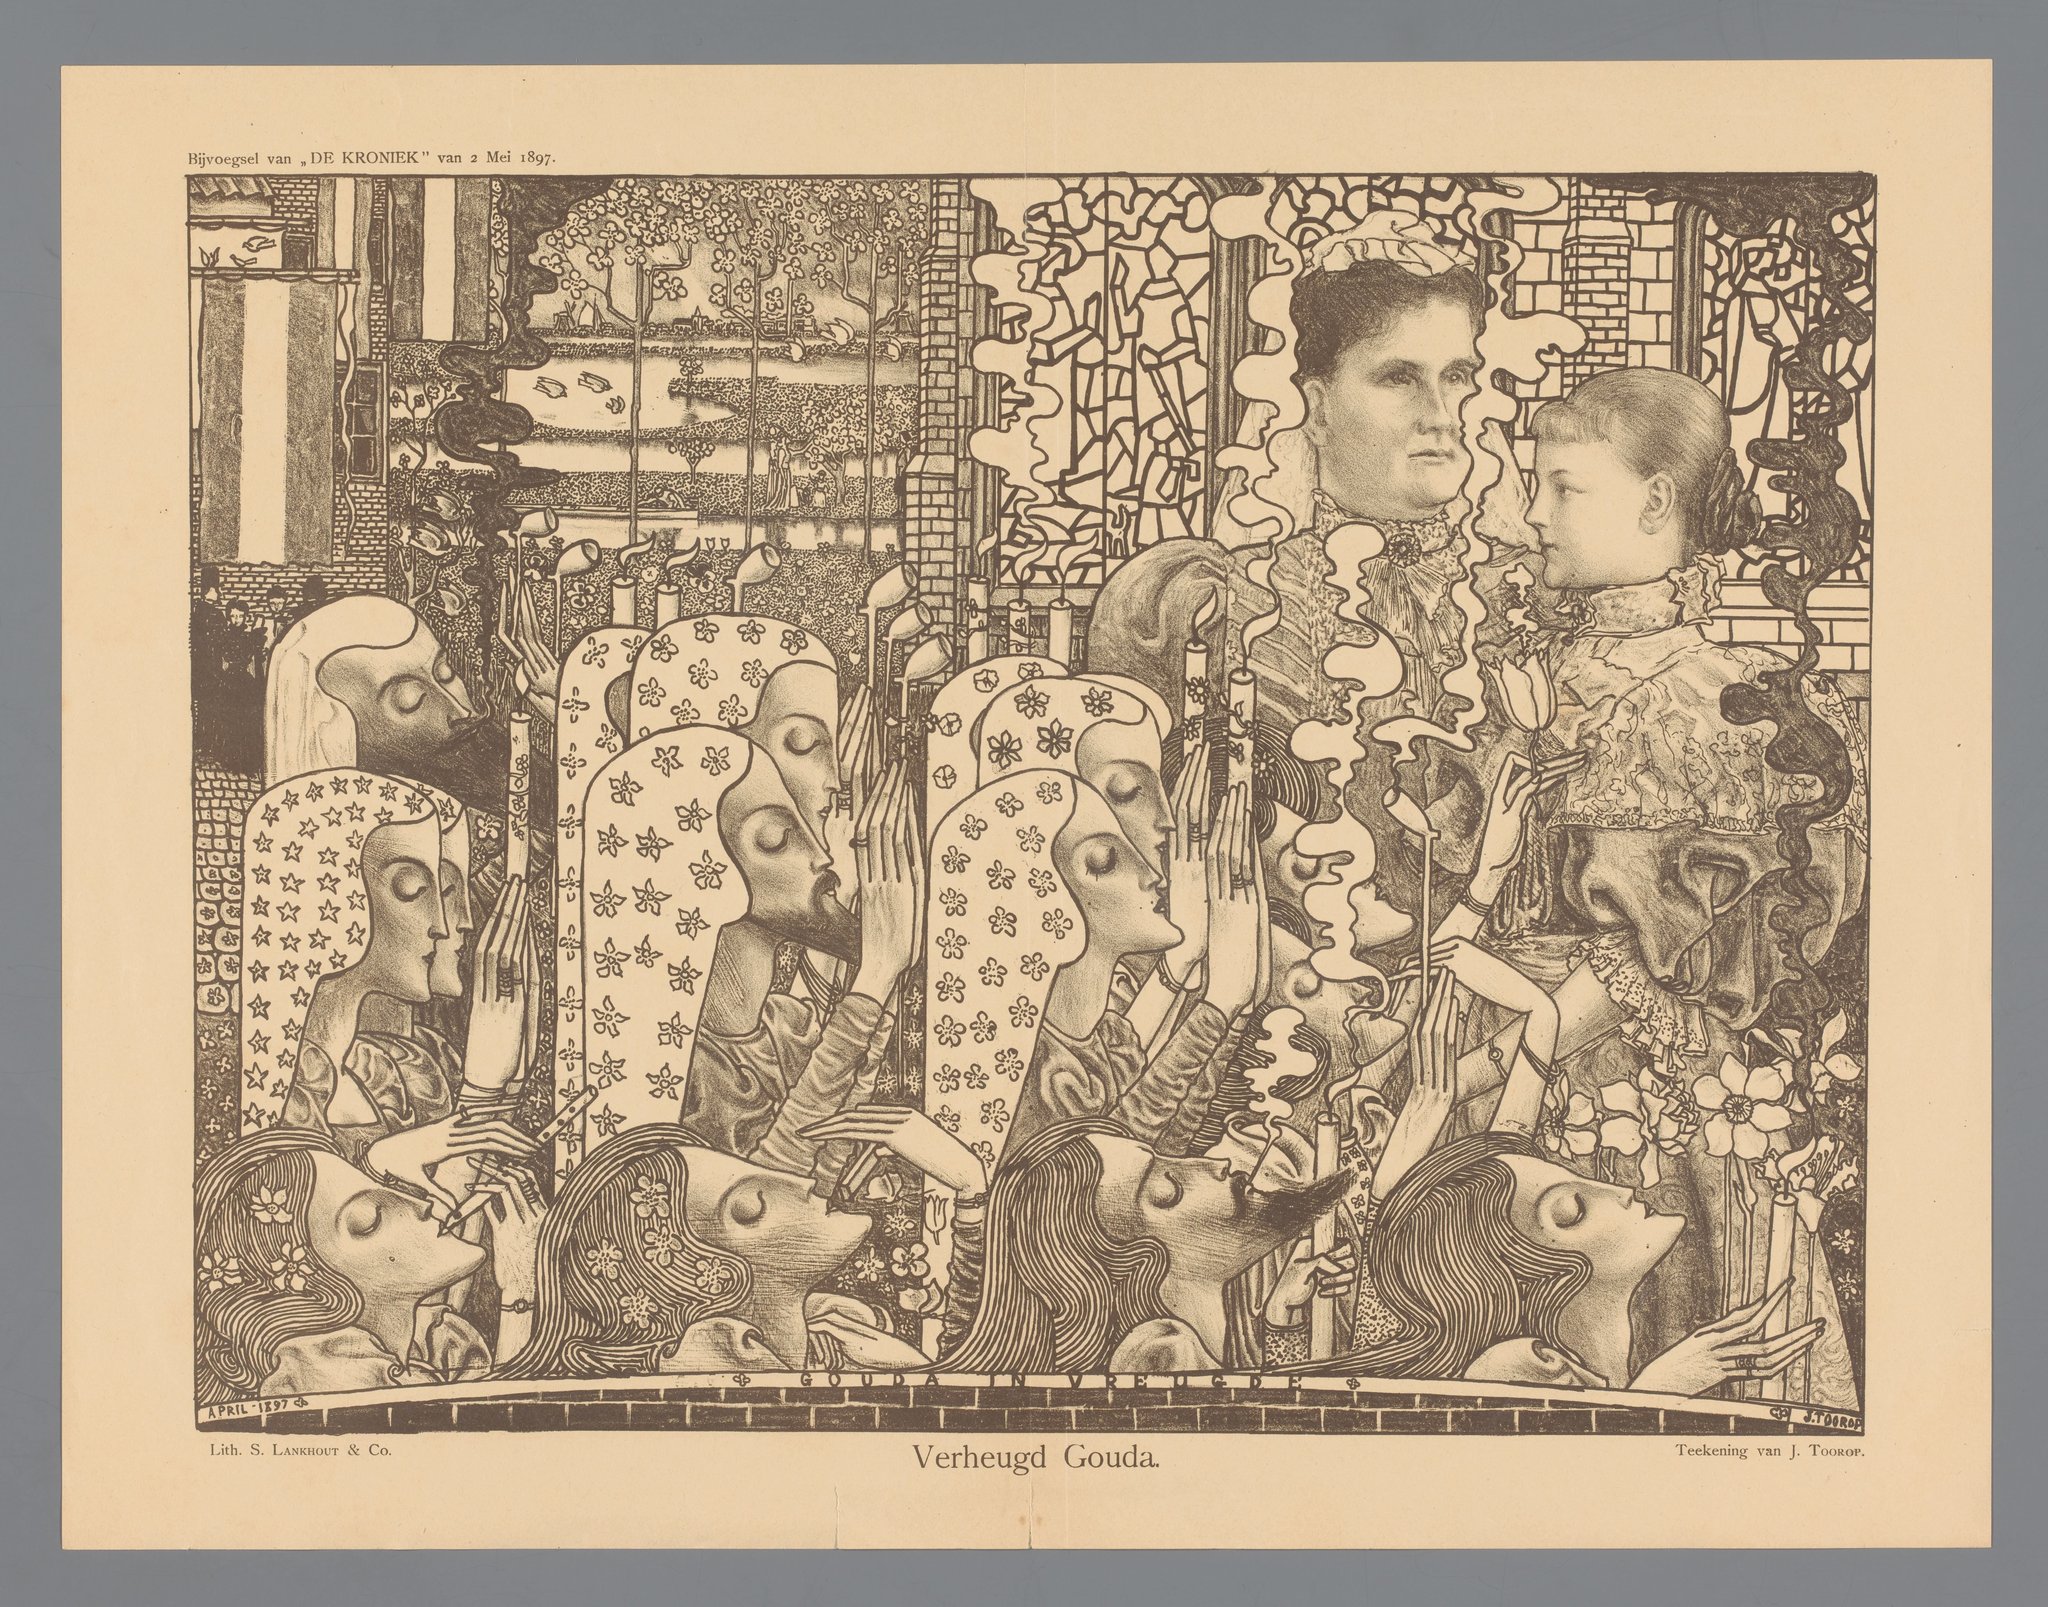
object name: print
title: Verheugd Gouda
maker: jan toorop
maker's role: draughtsman, painter, print maker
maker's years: 1858-1928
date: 1897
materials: paper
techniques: lithograph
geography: the hague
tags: the hague, print maker, wilhelmina of the netherlands, emma (queen consort of the netherlands), paying tribute to a ruler, queen, gouda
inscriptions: date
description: Gemaakt ter gelegenheid van het bezoek van prinses Wilhelmina aan Gouda. Rechtsachter portretten van prinses Wilhelmina en koningin-regentes Emma. De vrouwen op de voorgrond dragen attributen die te maken hebben met verschillende Goudse industrieën.